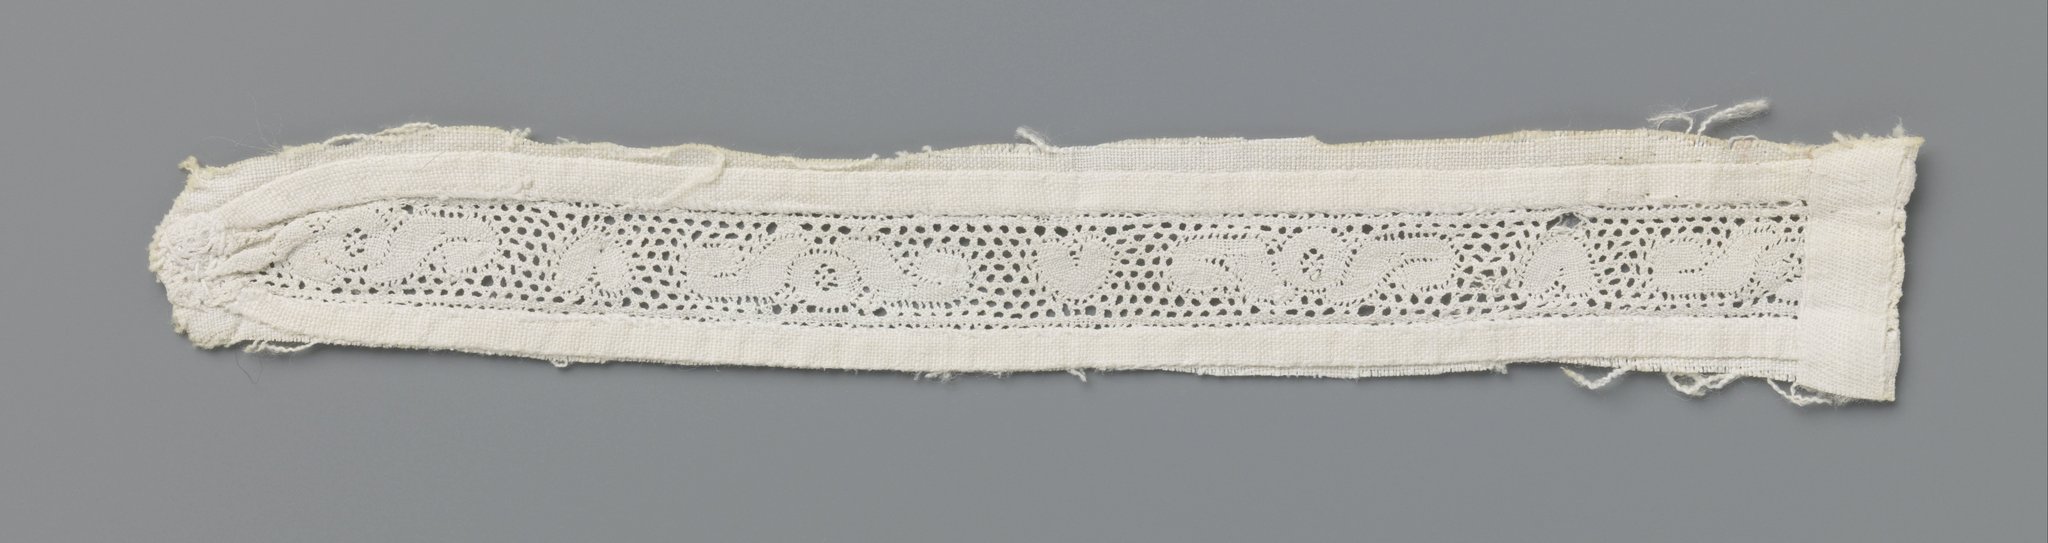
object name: entre deux, tussenzetsel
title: Tussenzetsel van kloskant met hartje en rond bloempje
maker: Anonymous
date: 1640-1660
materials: linen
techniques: lace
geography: antwerp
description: Tussenzetsel van naturelkleurige Hollandse kloskant. Het zich herhalende patroon bestaat afwisselend uit een hartje en een rond bloempje tussen twee langgerekte omkrullende bladeren. Het hartje staat afwisselend rechtop en omgekeerd. De motieven zijn met elkaar verbonden door een ronde traliegrond met vlechtslagen. De motieven zijn gemaakt in linnenslag met opengewerkte randjes en uitsparingen in het cirkelvormige bloemhart. Boven- en onderzijde van de strook zijn recht afgewerkt en vastgenaaid aan een fragment linnen afkomstig van een sloop.